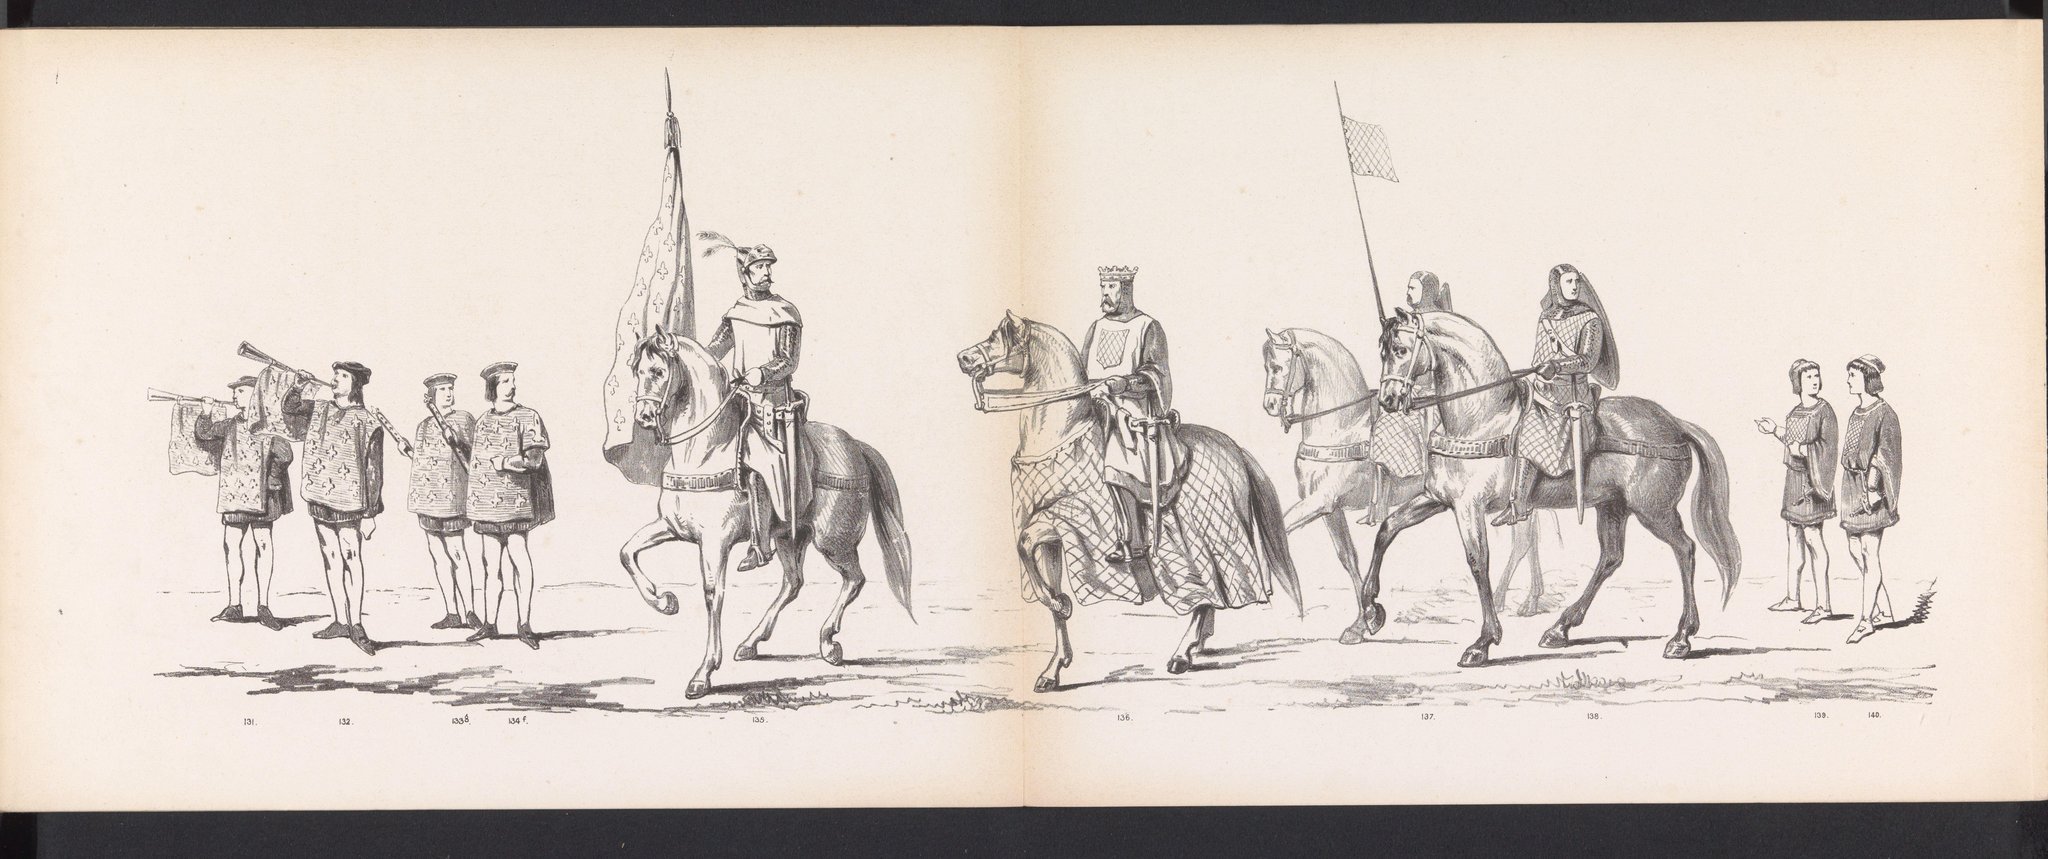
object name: print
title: Gecostumeerde optogt gehouden door de leden van het Leidsche studenten-corps den 6den Junij 1865, ter viering van den 290sten verjaardag der Leidsche Hoogeschool, voorstellende: de intogt der Hollanders binnen Zierikzee onder Jonker Willem, Grave van Oostervant, op den 12den augustus Anno 1304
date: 1865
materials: paper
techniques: lithograph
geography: netherlands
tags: students' pageant, costumes used in pageants, leiden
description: Historische gekostumeerde optocht van de studenten van de Leidse Hogeschool gehouden op 6 juni 1865 ter gelegenheid van het 290-jarig bestaan van de Hogeschool. De optocht verbeeldt de intocht van de Hollanders binnen Zierikzee op 12 augustus 1304. Elfde plaat met de groepen genummerd 131-140. Onderdeel van de serie van 16 aaneen geplakte bladen.